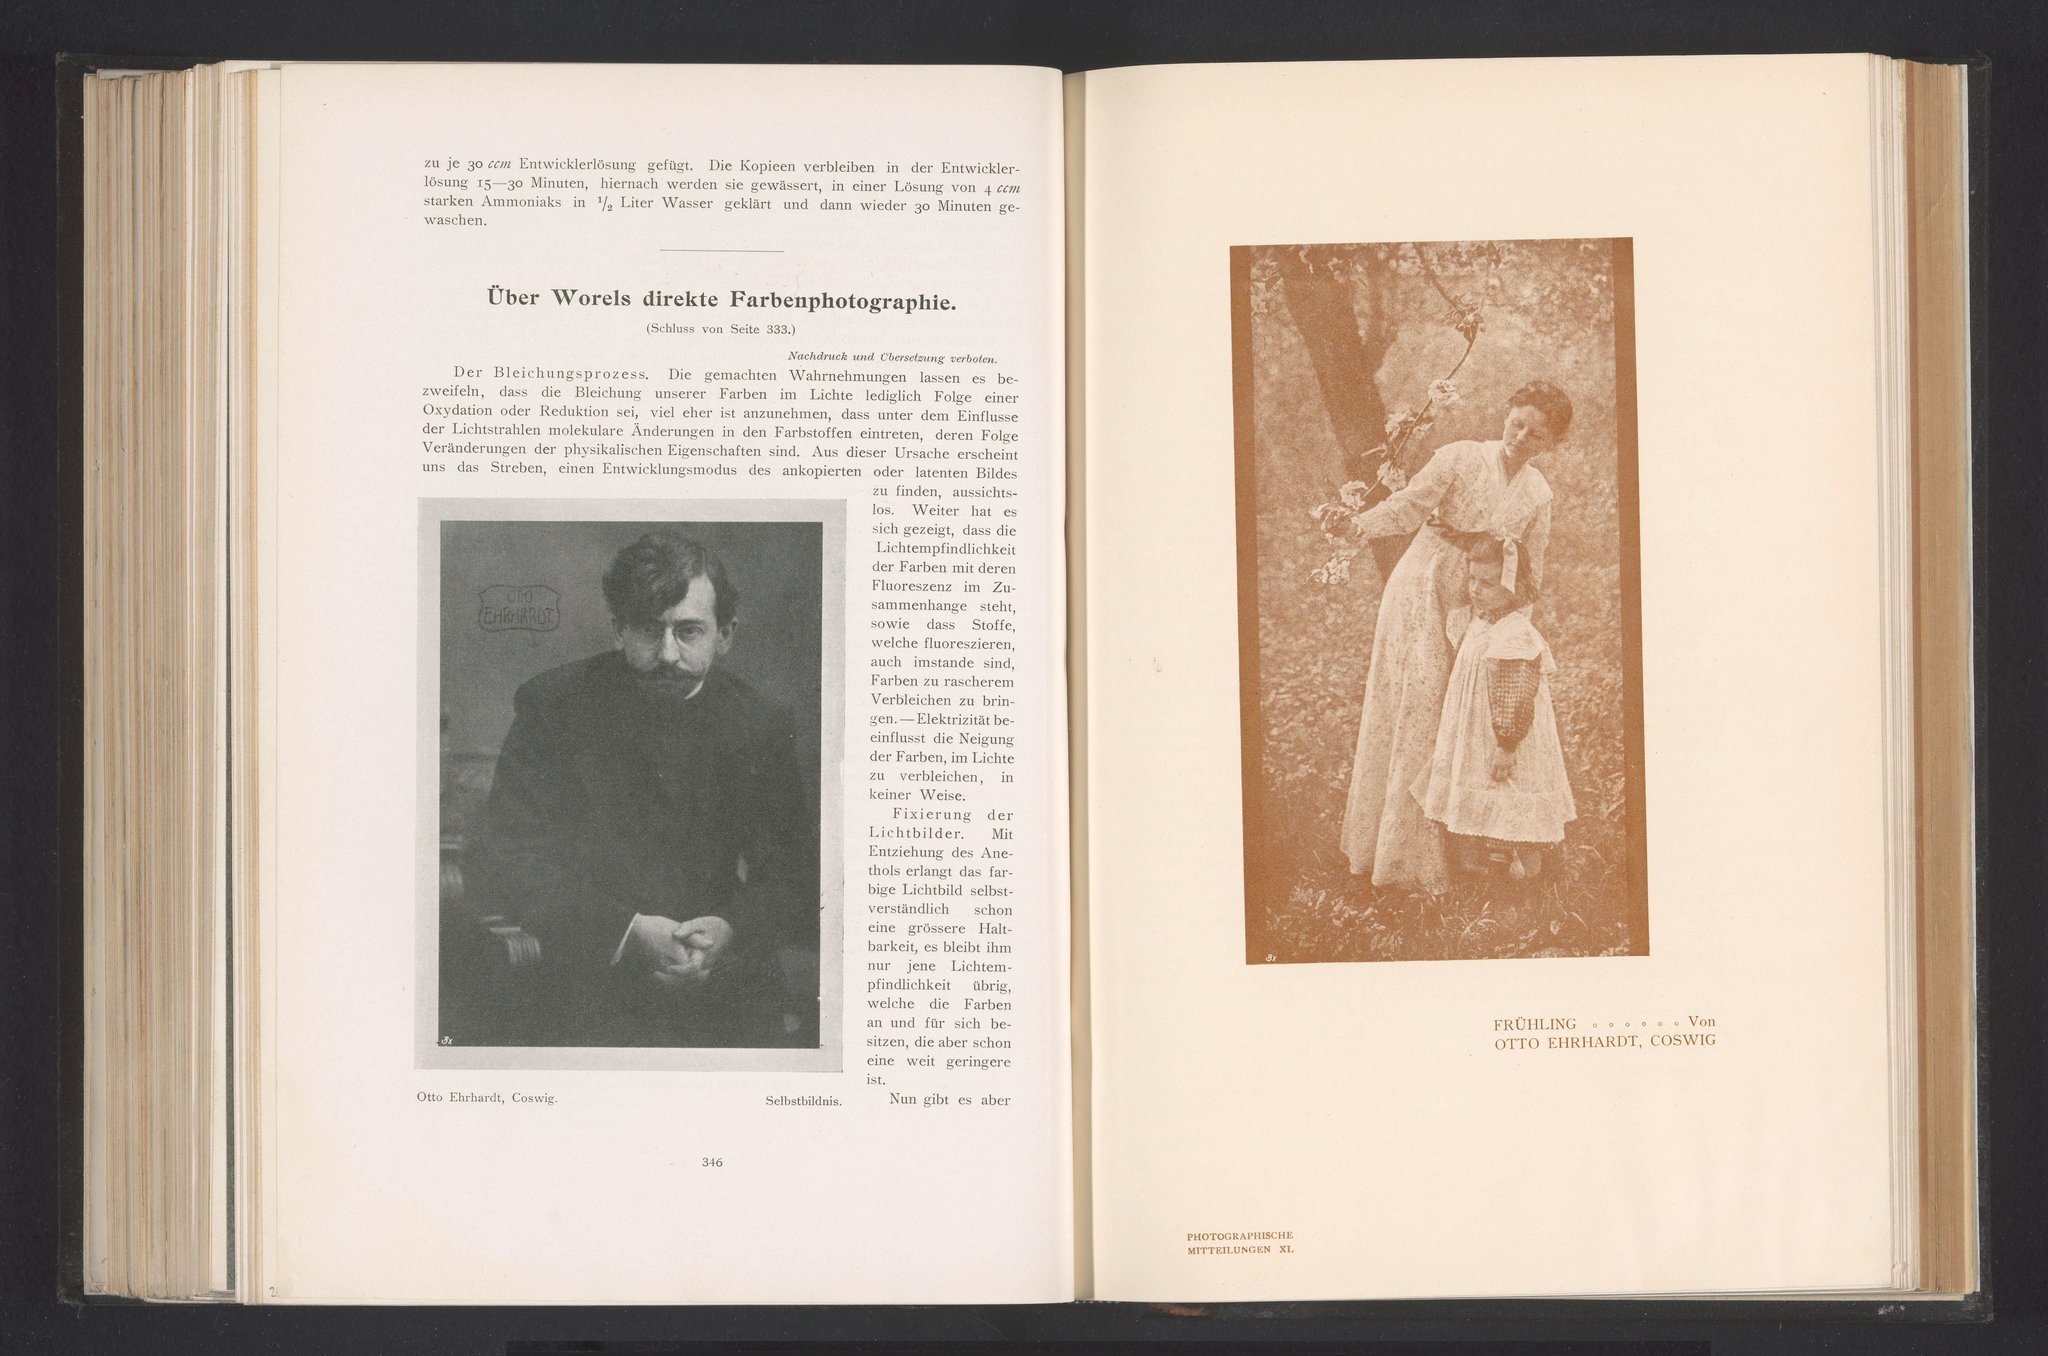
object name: photomechanical print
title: Frühling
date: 1898-1903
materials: paper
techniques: autotype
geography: coswig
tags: flowers, historical persons - bb - woman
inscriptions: monogram: ‘BX’